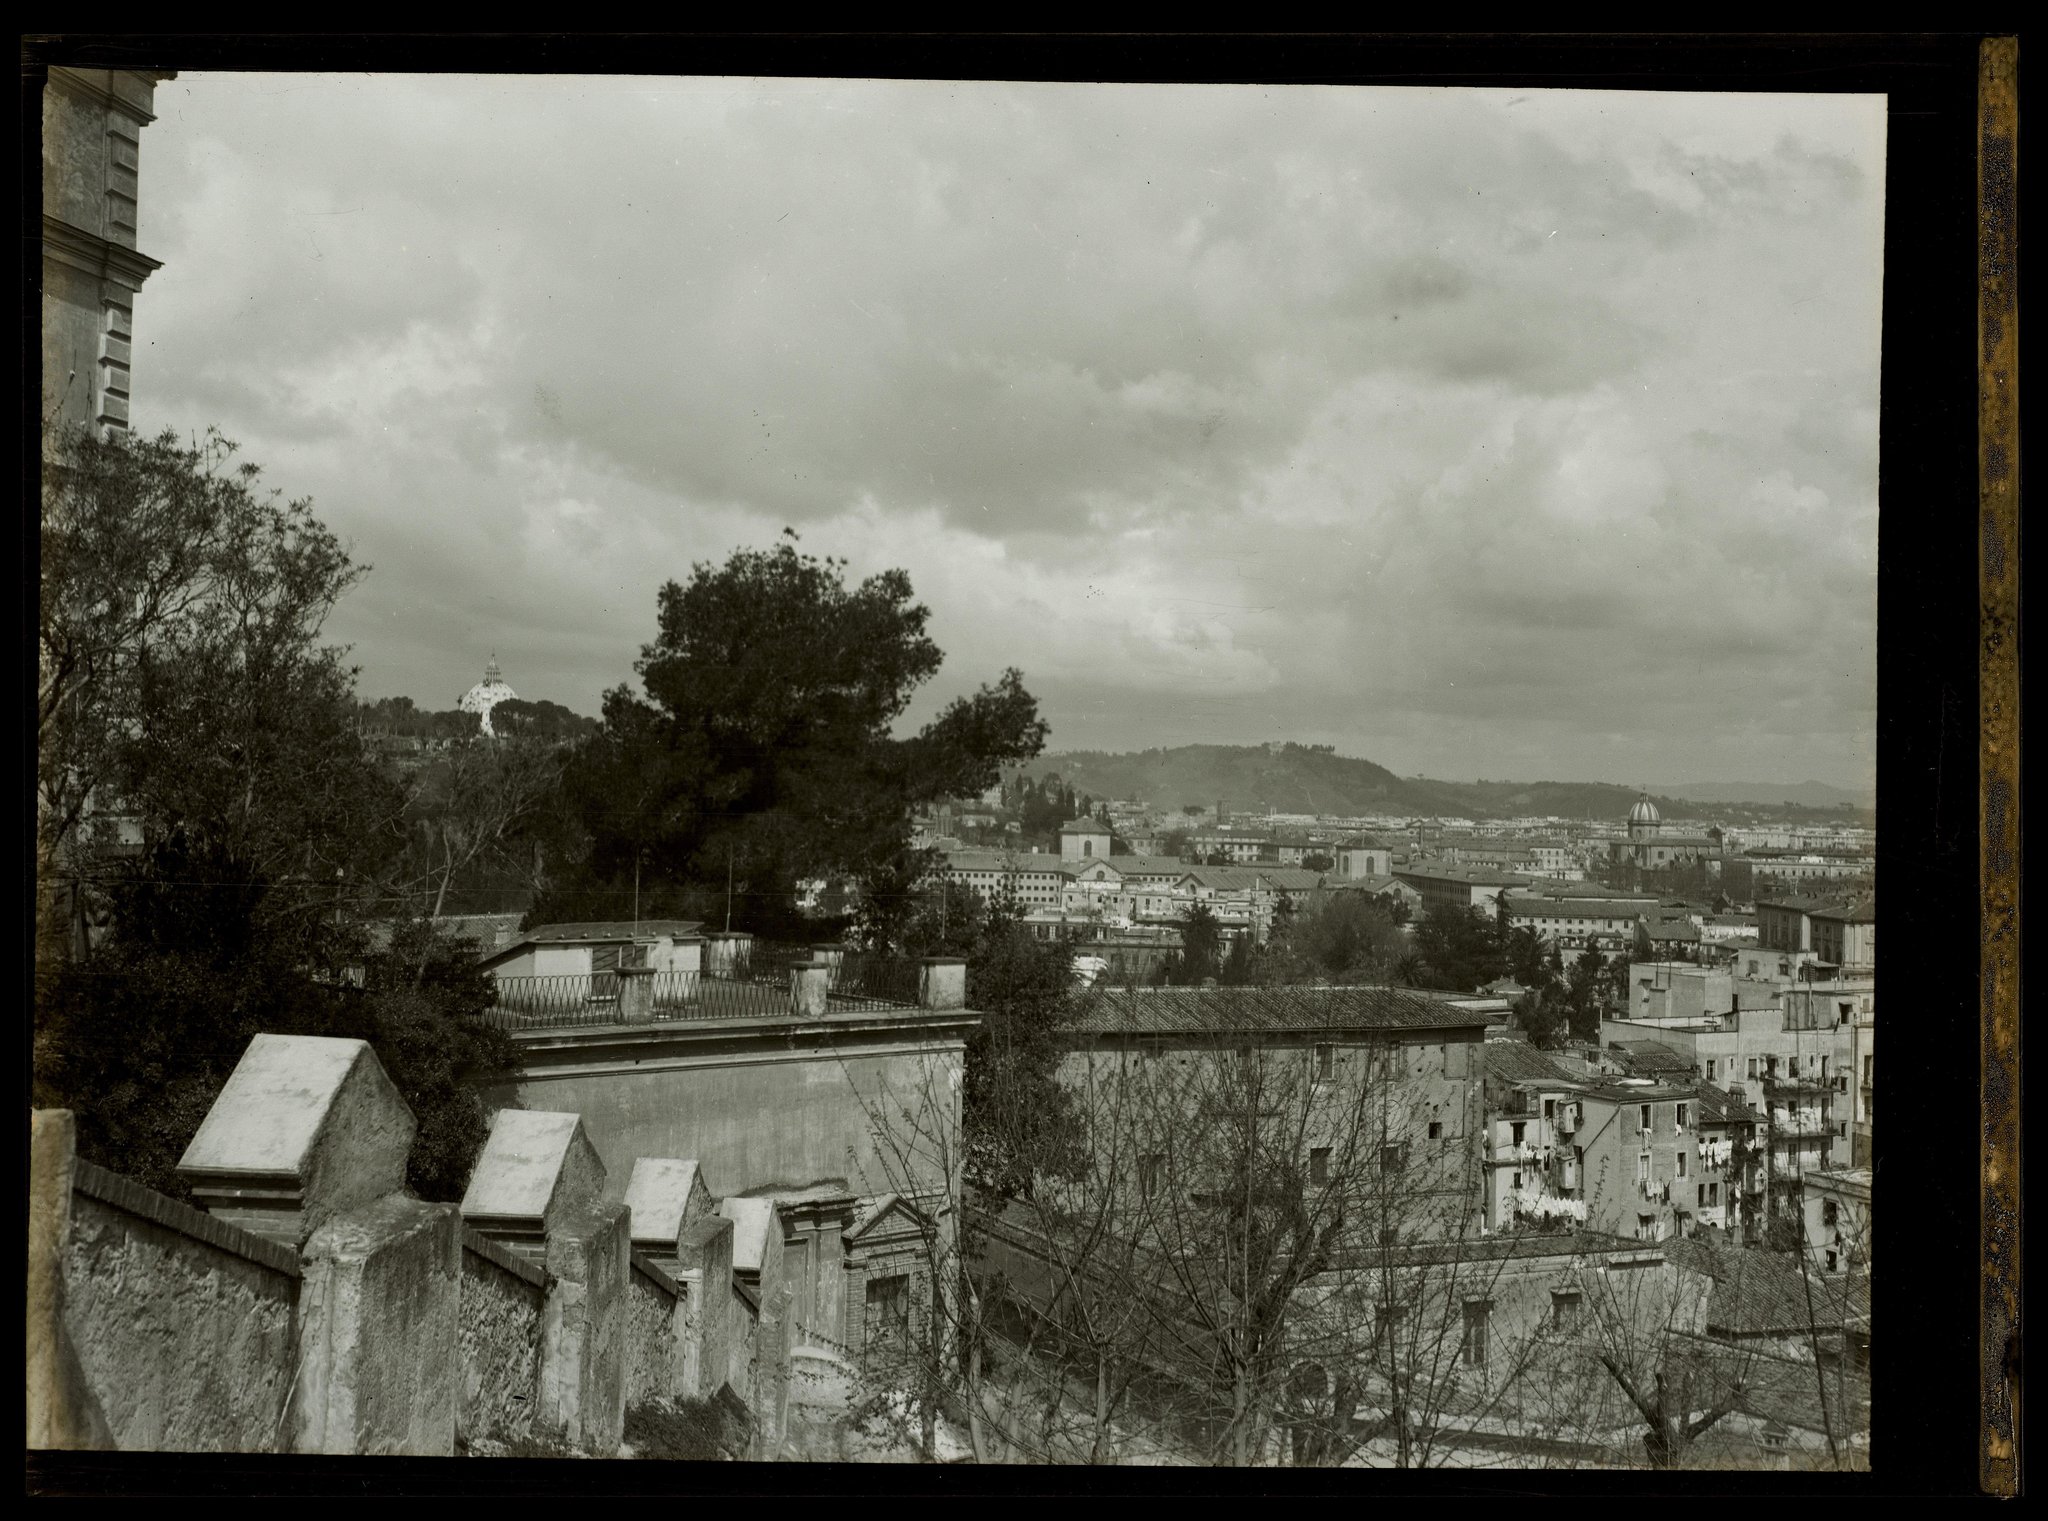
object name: negative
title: Filmnegatief met opname van Rome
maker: Anonymous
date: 1907-1935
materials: film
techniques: gelatin silver negative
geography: rome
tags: rome